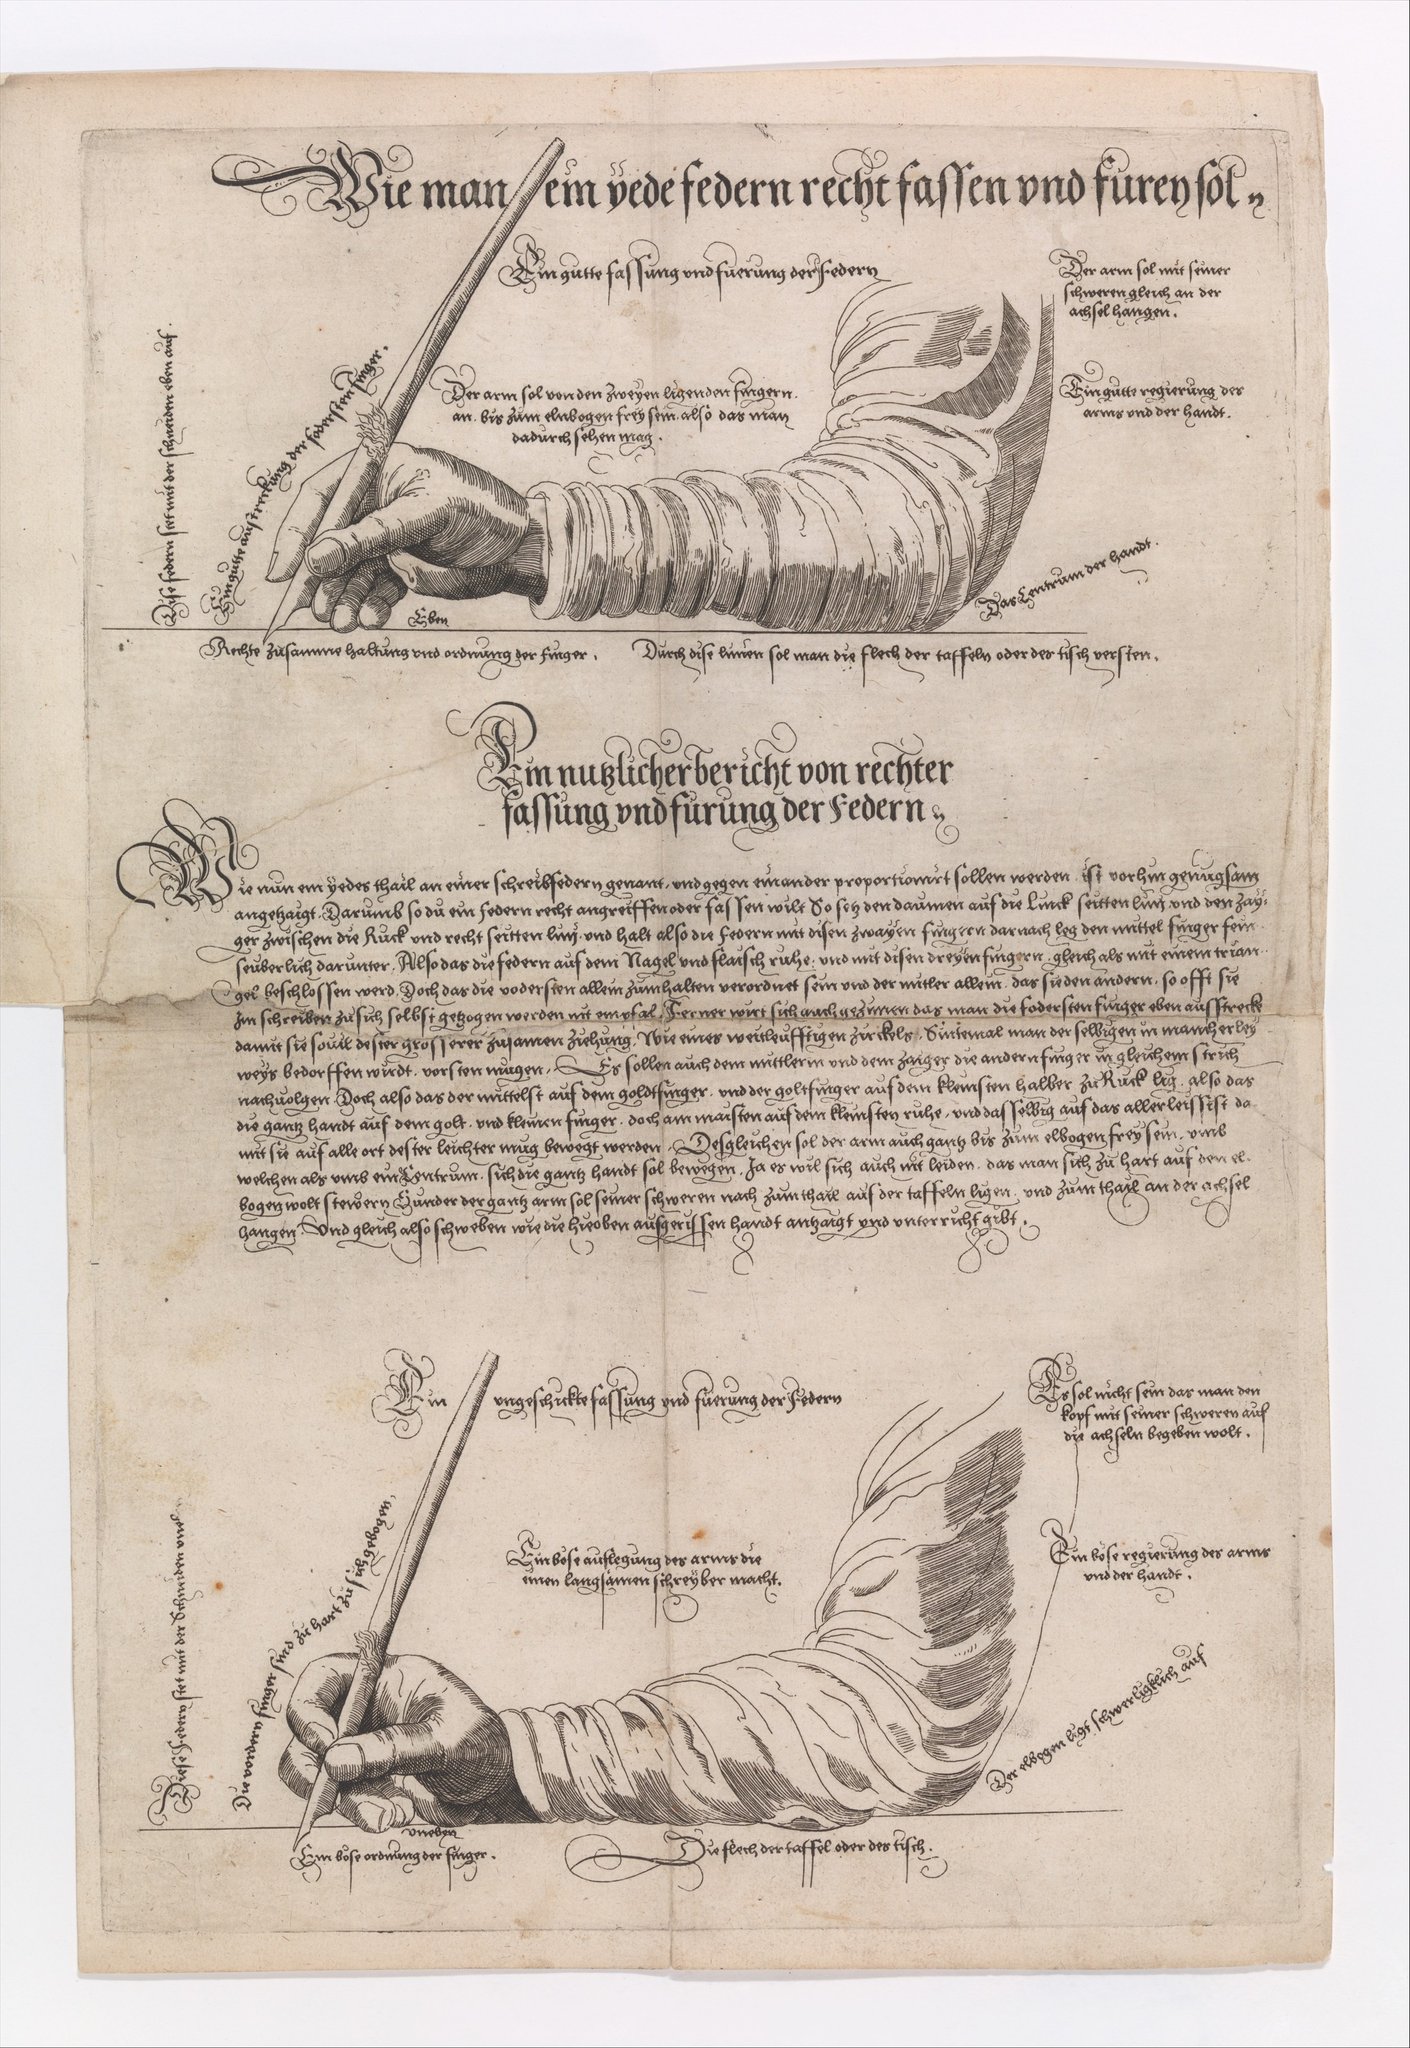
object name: book print ornament architecture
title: Schreibkunst (The Art of Writing)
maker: anton neudörffer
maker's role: artist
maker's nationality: german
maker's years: 1571-1628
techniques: etching, woodcut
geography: nuremberg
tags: hands,writing,pens